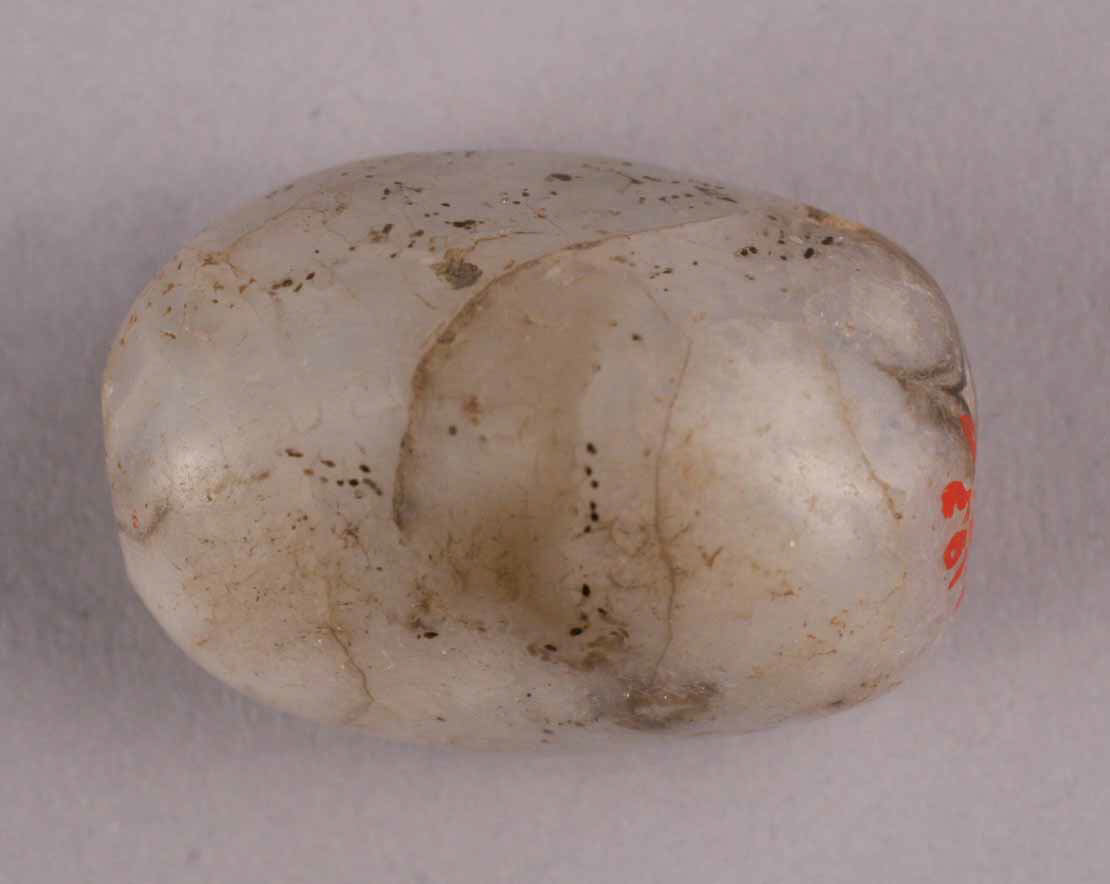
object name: bead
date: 701-1300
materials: stone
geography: iran